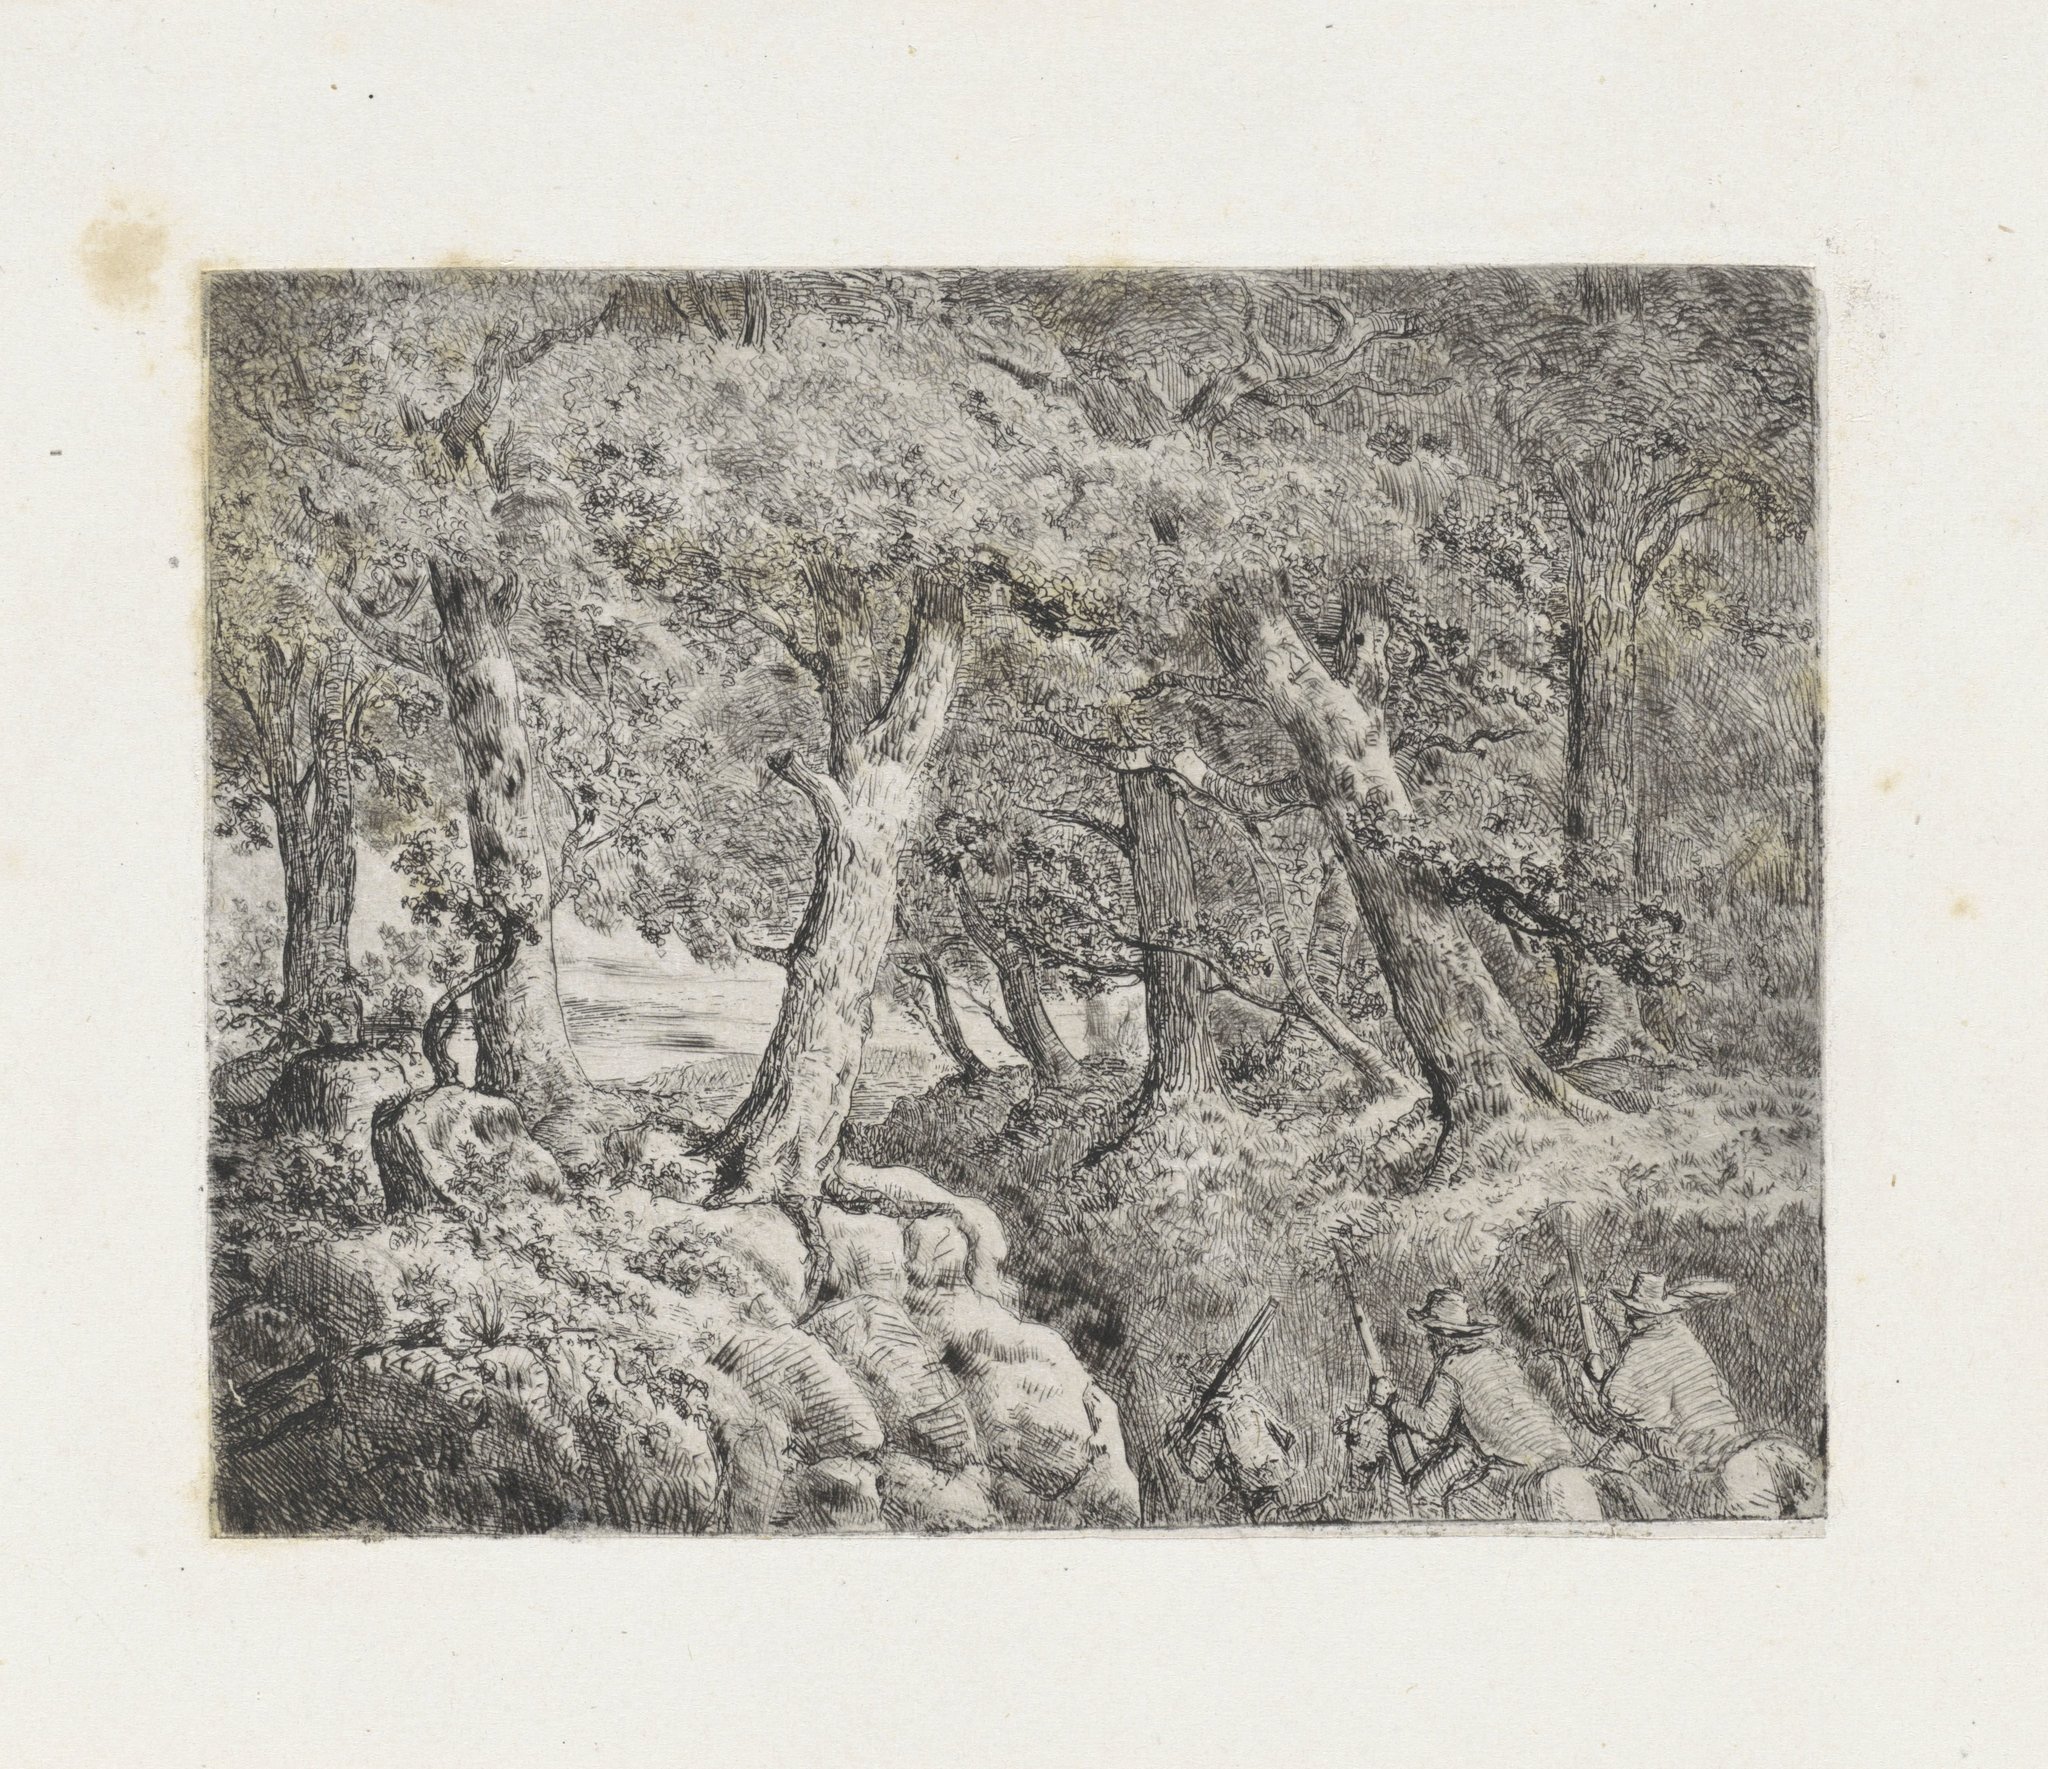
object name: print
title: Ruiters met geweren in een holle weg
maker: louis charles hora siccama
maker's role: draughtsman, print maker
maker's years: 1807-1880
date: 1822-1880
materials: paper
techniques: drypoint, engraving, etching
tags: firearms: rifle, galloping horse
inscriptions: collector's mark: Lugt 2228